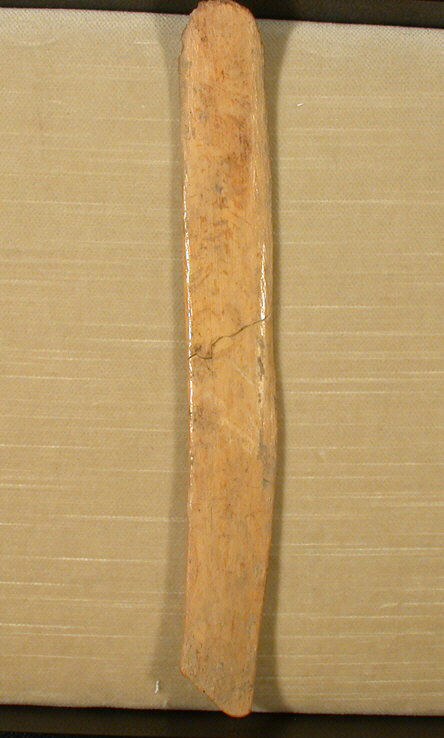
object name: spatula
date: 4000-3001 BCE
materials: bone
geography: iran